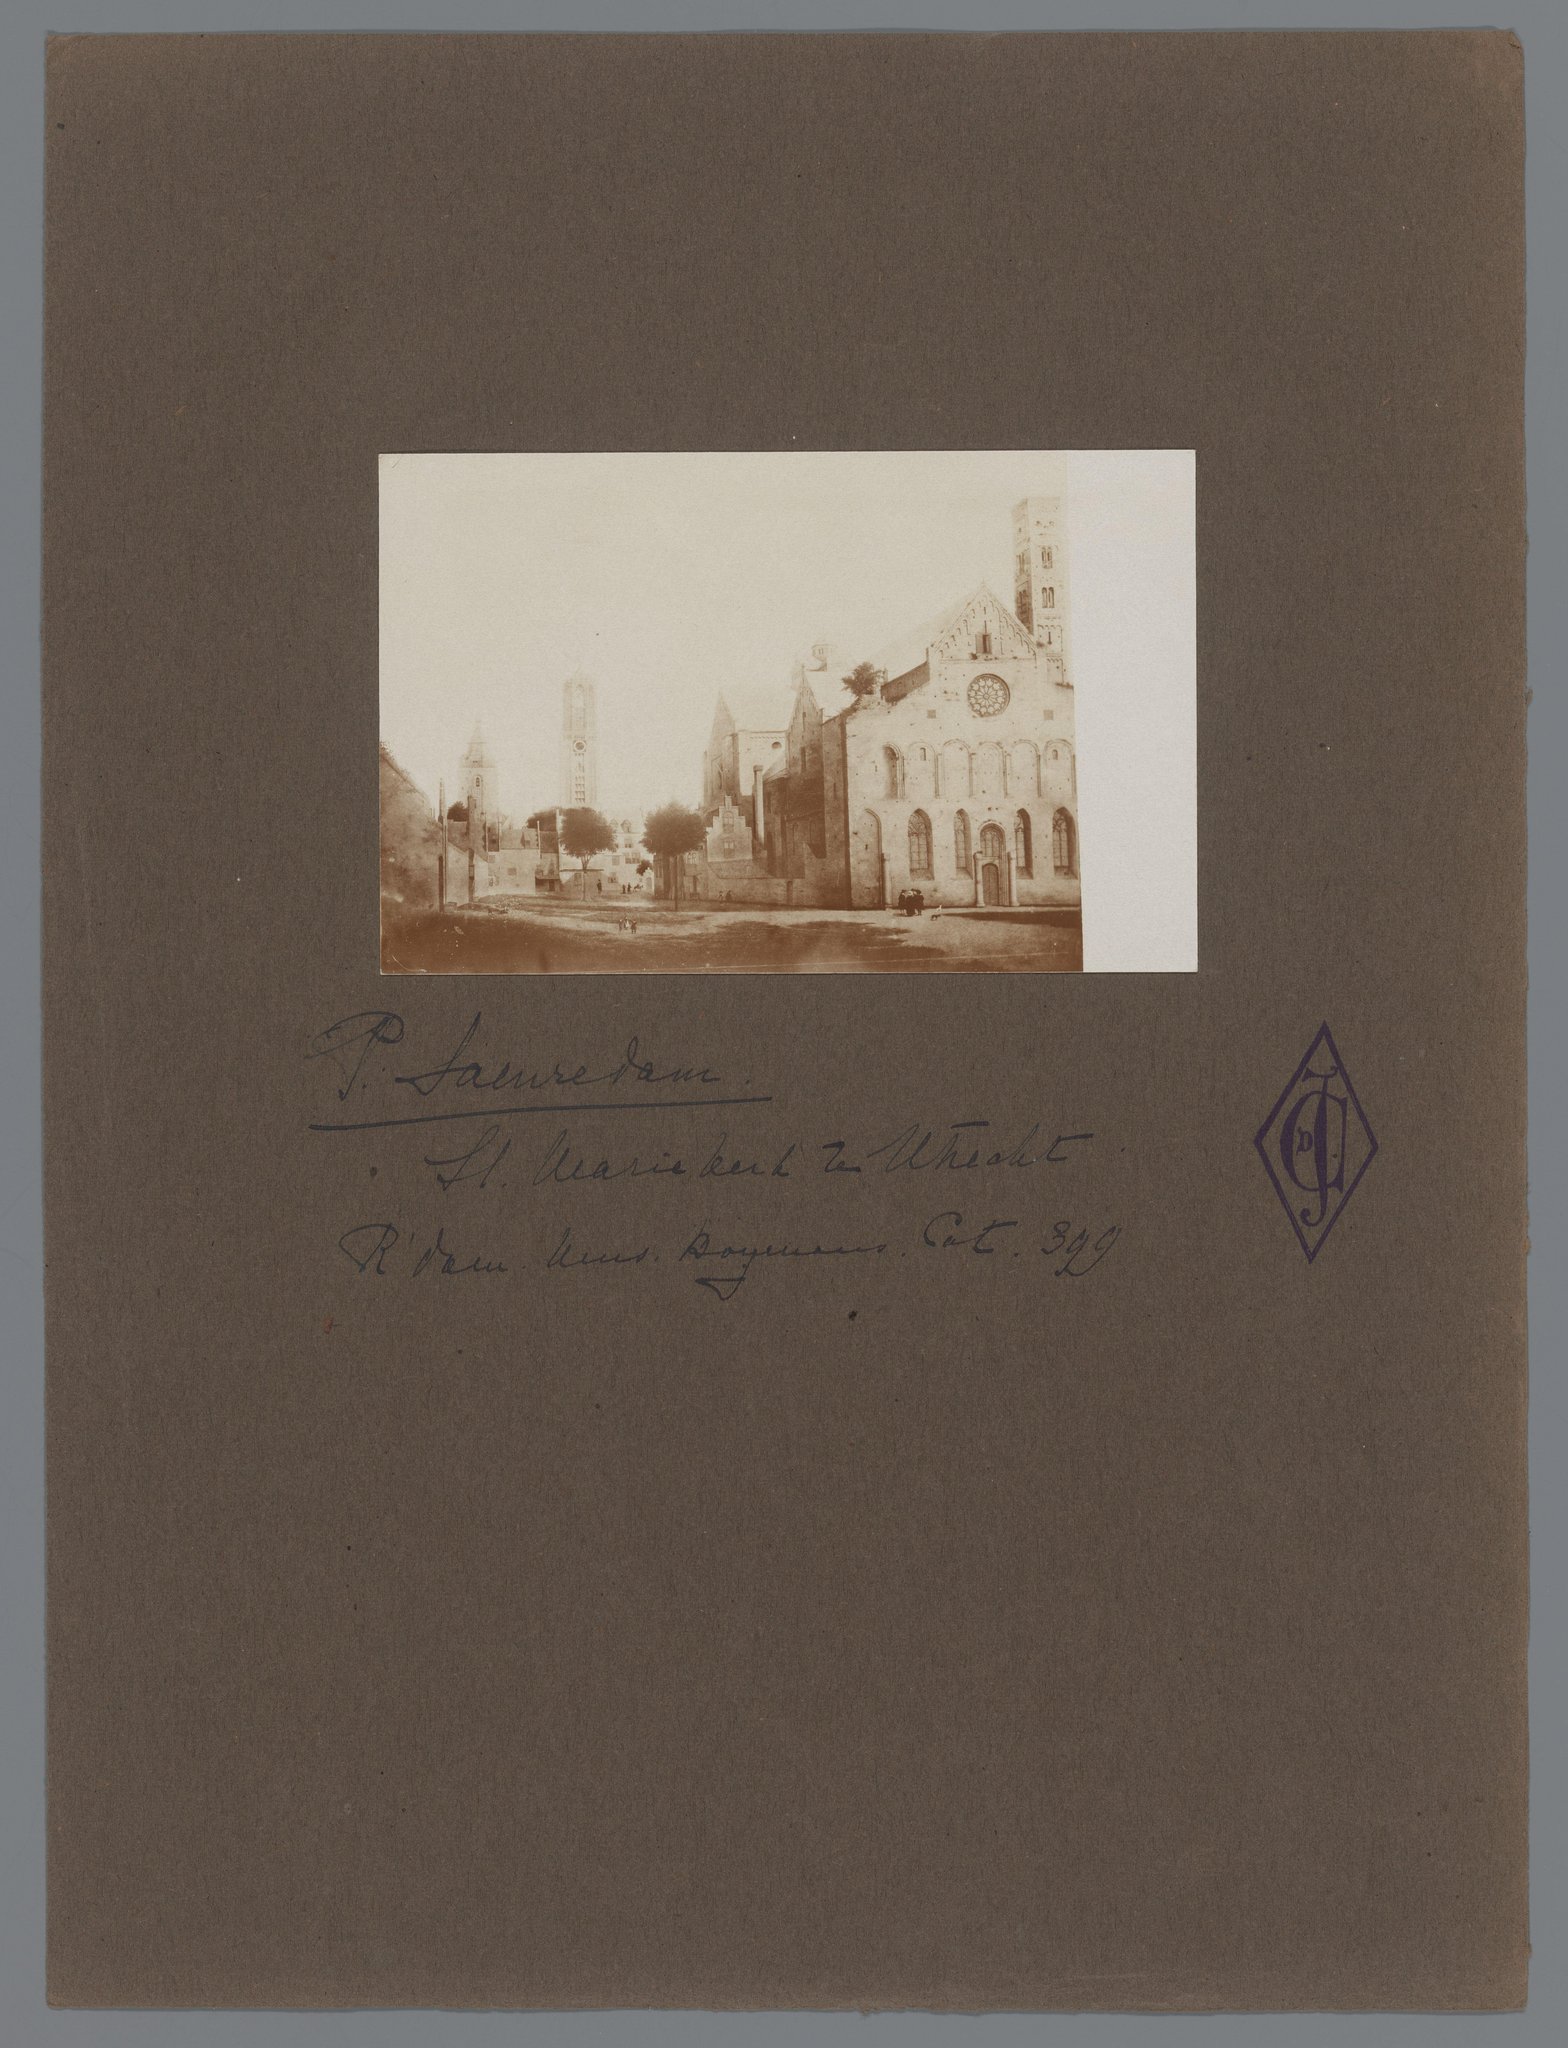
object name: photograph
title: Fotoreproductie van De Mariaplaats met de Mariakerk in Utrecht door Pieter Jansz. Saenredam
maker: Anonymous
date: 1880-1910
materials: cardboard, photographic support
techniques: collodion silver print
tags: church (exterior)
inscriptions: monogram: ‘[JCD]’, annotation: ‘P. Saenredam/ St Mariakerk te Utrecht/ [R'dam ... Boymans. Cat. 399]’